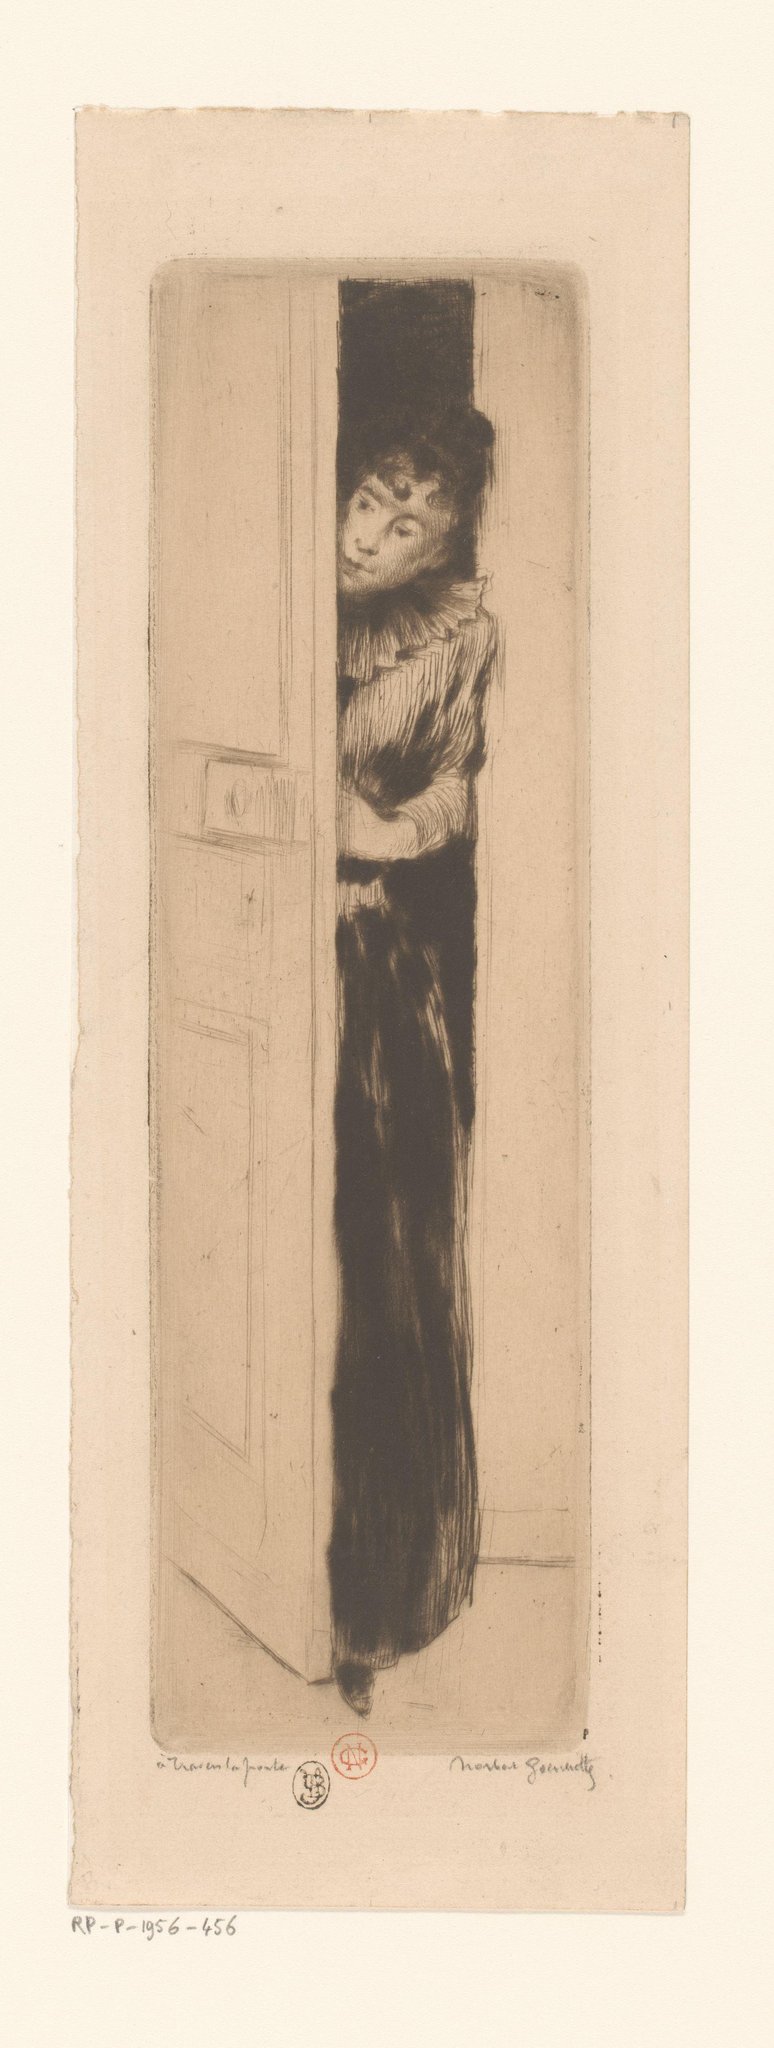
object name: print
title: Jonge vrouw in een deuropening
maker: norbert goeneutte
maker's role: draughtsman, painter, print maker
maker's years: 1854-1894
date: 1876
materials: paper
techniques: drypoint, intaglio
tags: opening the door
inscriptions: stamp: Lugt 1182, collector's mark: Lugt 2760, collector's mark: Lugt 421, collector's mark: Lugt 2228